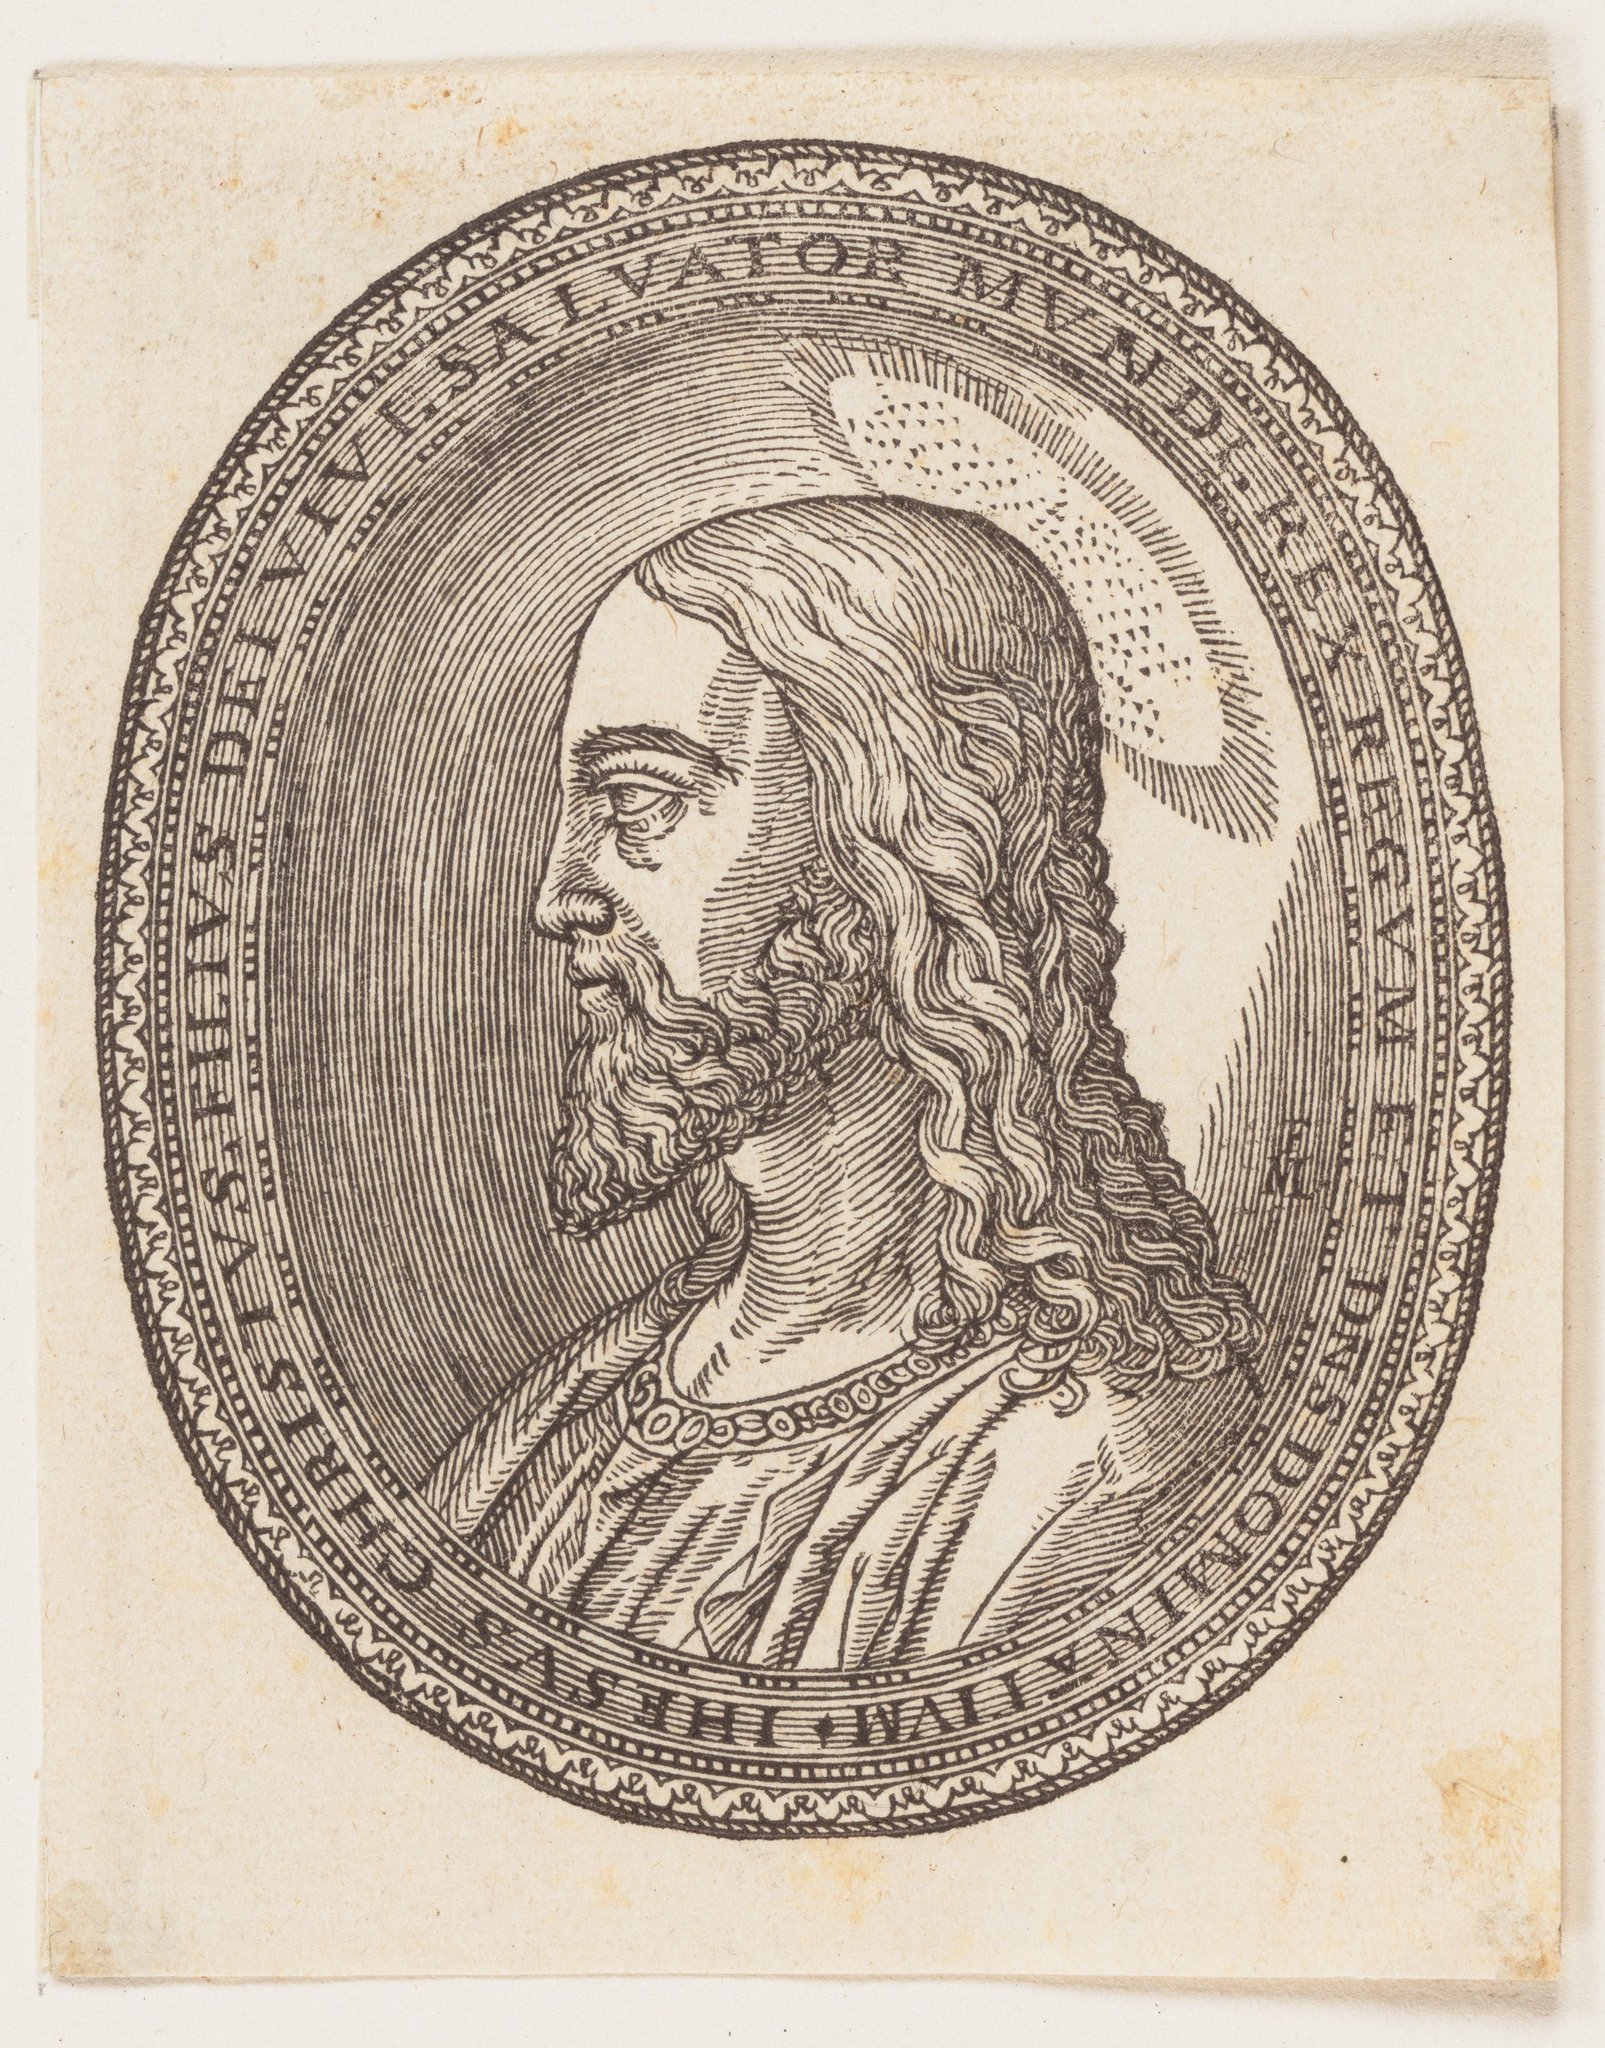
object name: print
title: Christ, left profile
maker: melchior lorck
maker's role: artist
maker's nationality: danish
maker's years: 1526-1588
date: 1501-1600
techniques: woodcut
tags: profiles,christ